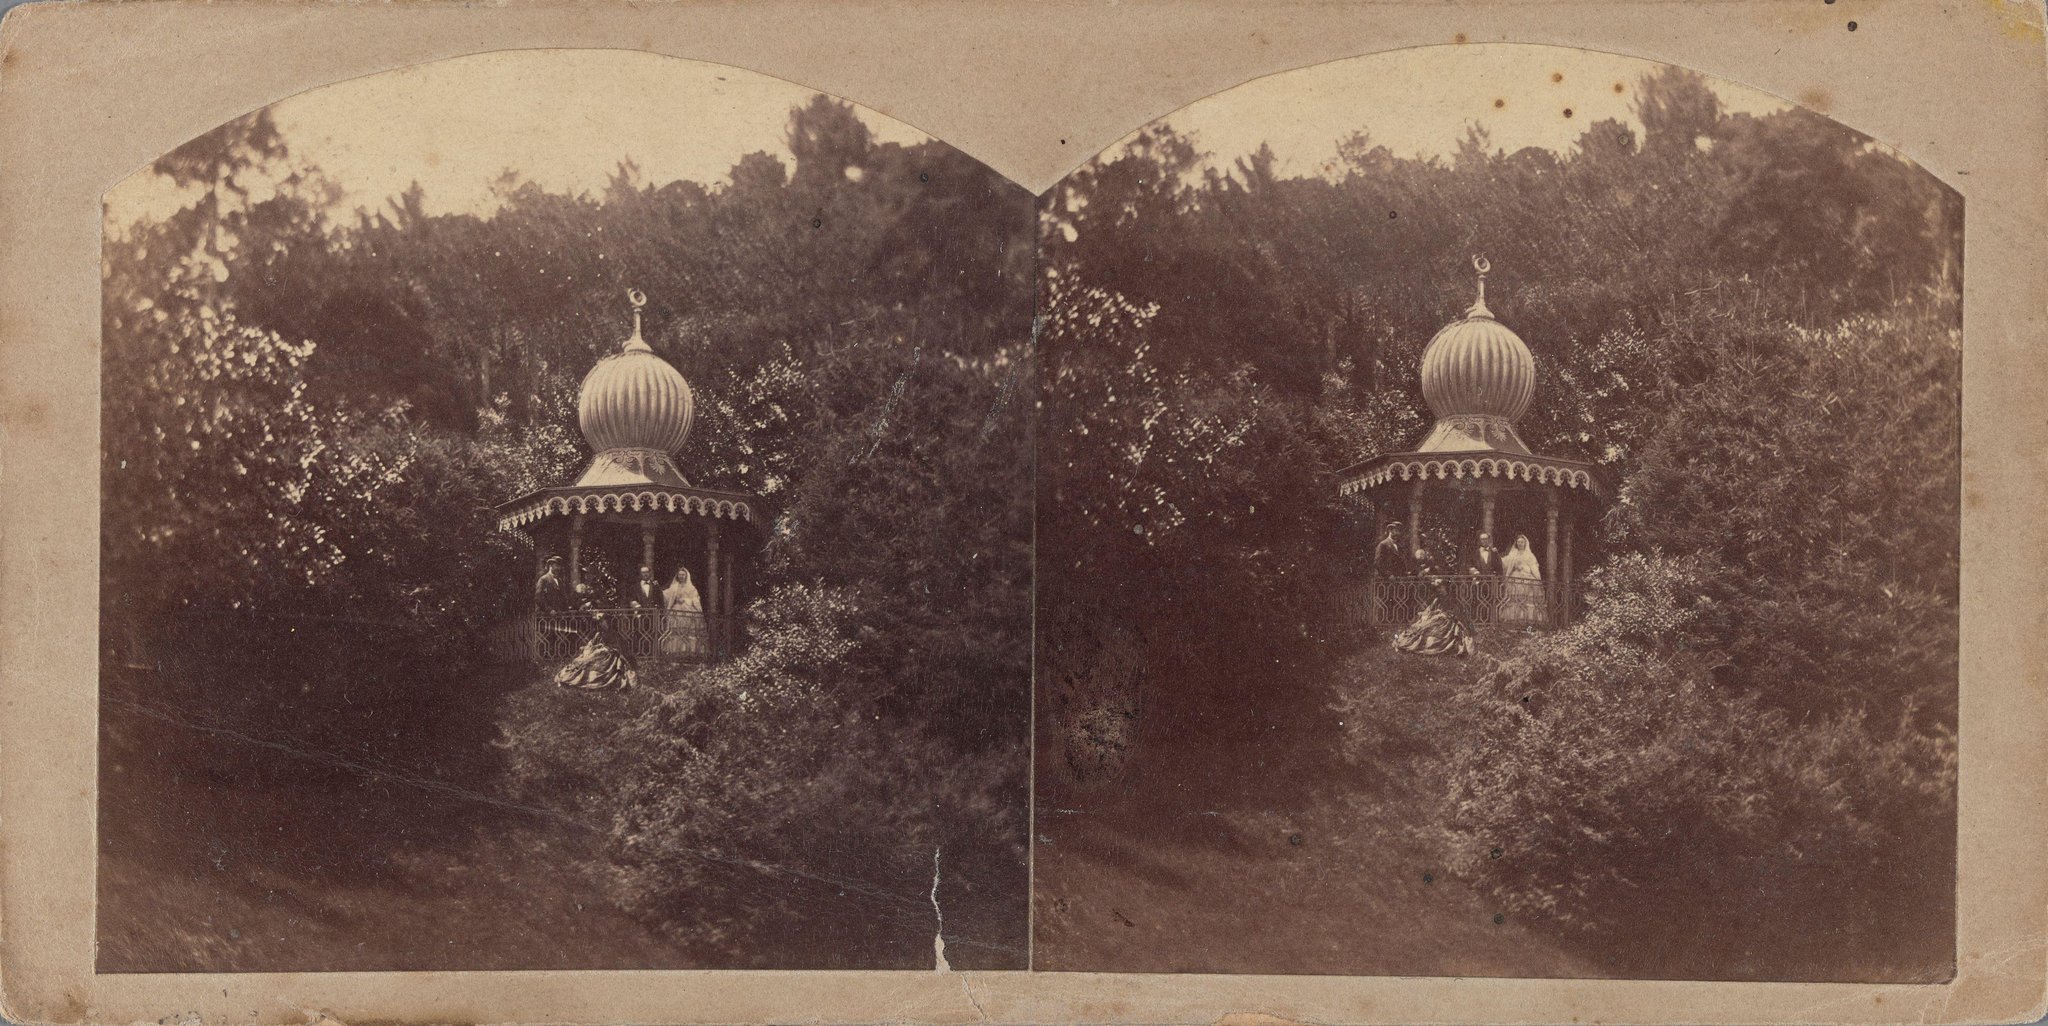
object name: stereograph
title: Gezelschap in de pagode in de tuin van de Villa Pallavicini in Pegli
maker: adolphe godard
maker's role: fotograaf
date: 1860-1880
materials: cardboard, paper, photographic support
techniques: albumen print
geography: pegli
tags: temple, shrine ~ hinduism, buddhism, jainism, garden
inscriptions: inscription: ‘Adolphe Godard Crosa del Diavolo No. 37. à Gênes’, number: ‘126’